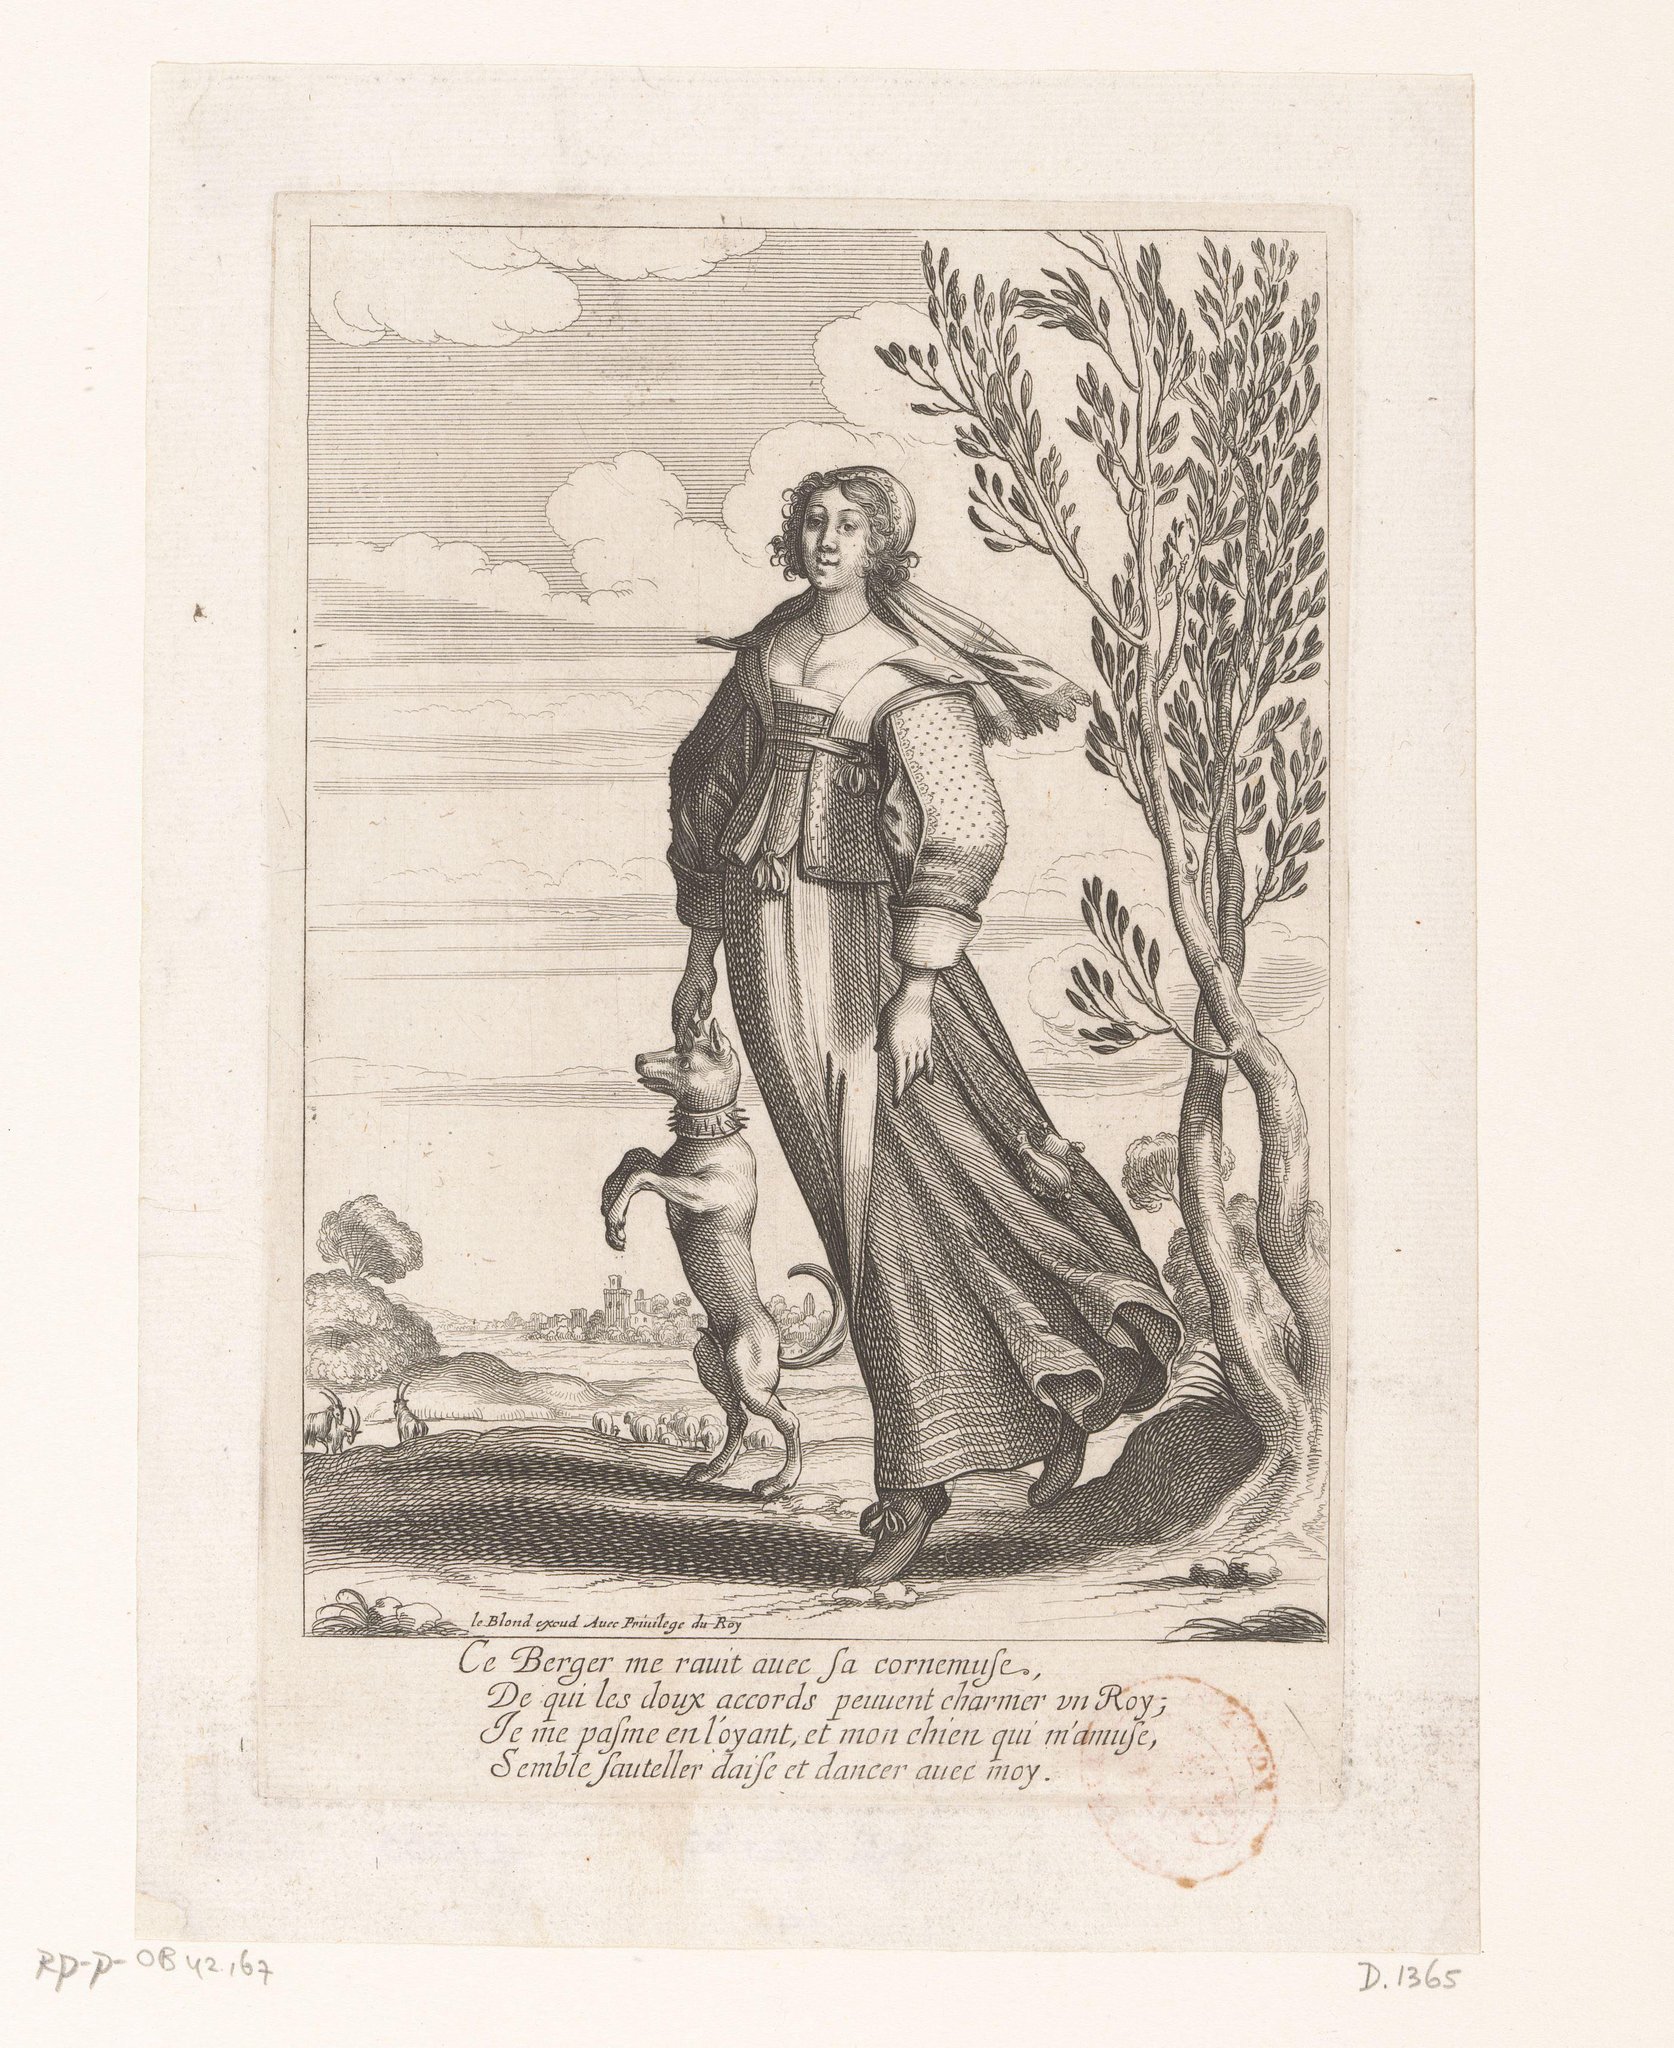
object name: print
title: Herderin met hond op achterpoten staand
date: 1626-1628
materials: paper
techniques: engraving, etching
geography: paris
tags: herding, herdsman, herdswoman, shepherd, shepherdess, cowherd, etc., dog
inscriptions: collector's mark: Lugt 240